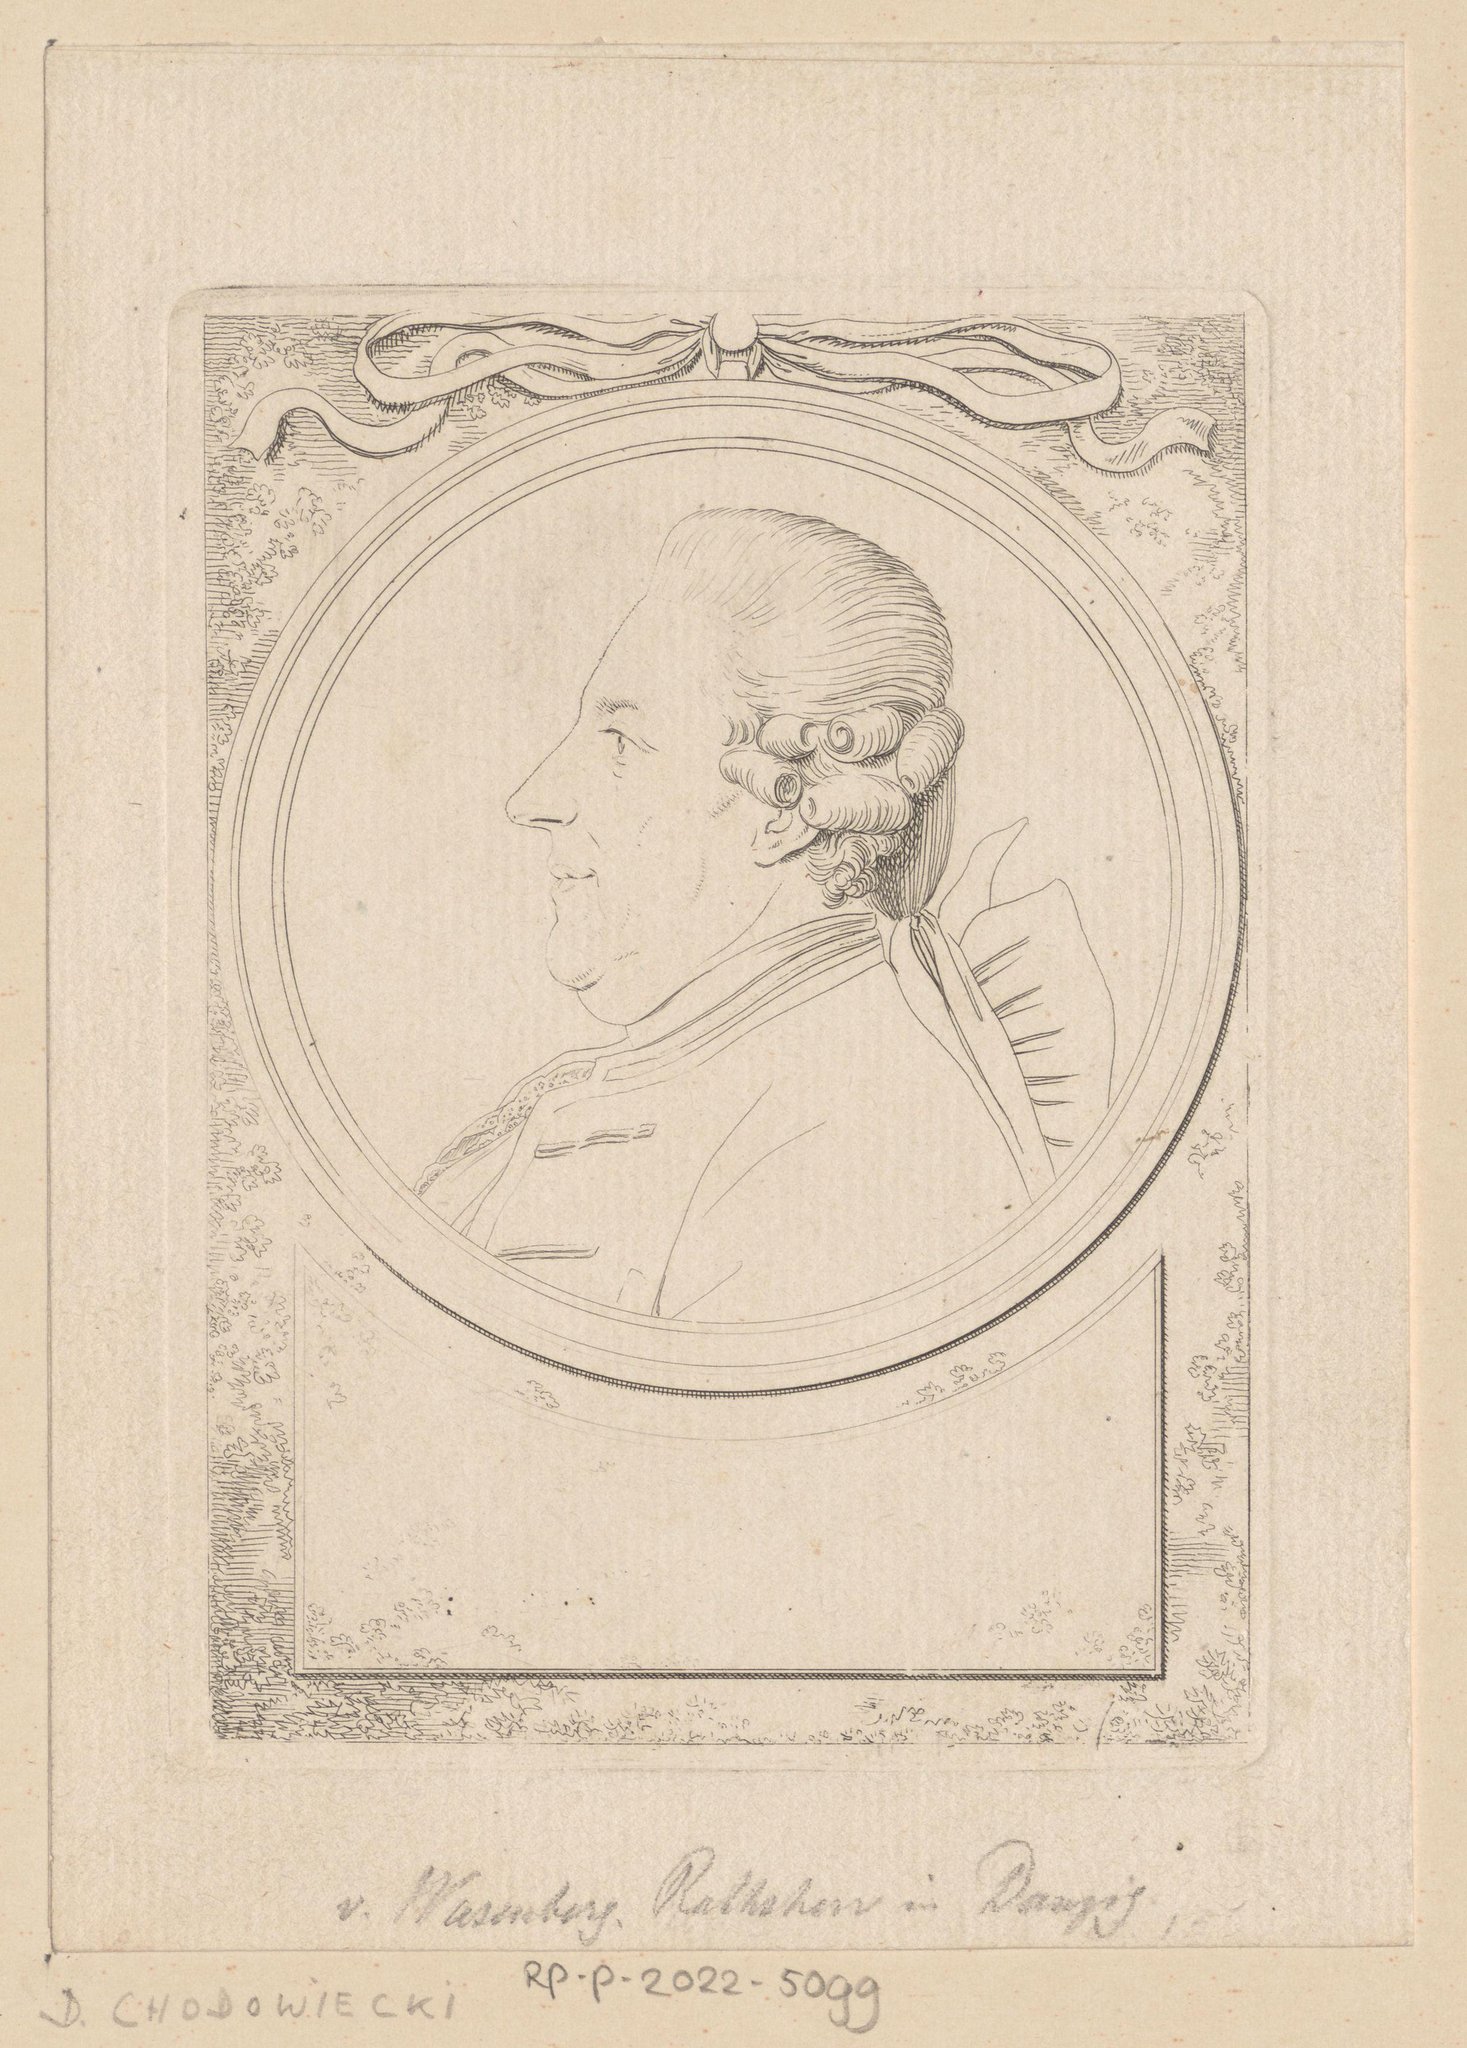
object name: print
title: Portret van Johann Anton Janson von Waasberghe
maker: daniel nikolaus chodowiecki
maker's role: draughtsman, print maker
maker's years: 1726-1801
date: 1773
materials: paper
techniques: etching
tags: historical persons